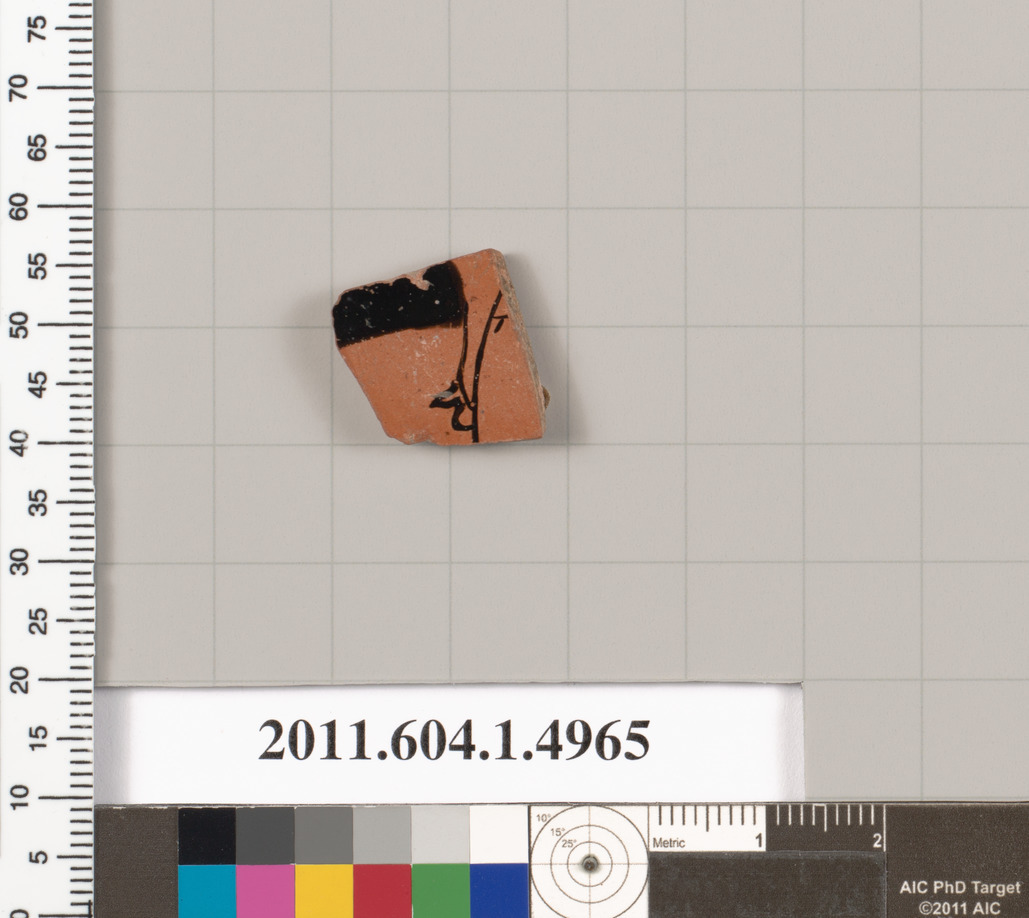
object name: kylix fragment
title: Terracotta fragment of a kylix (drinking cup)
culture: greek, attic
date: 500-480 BCE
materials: terracotta